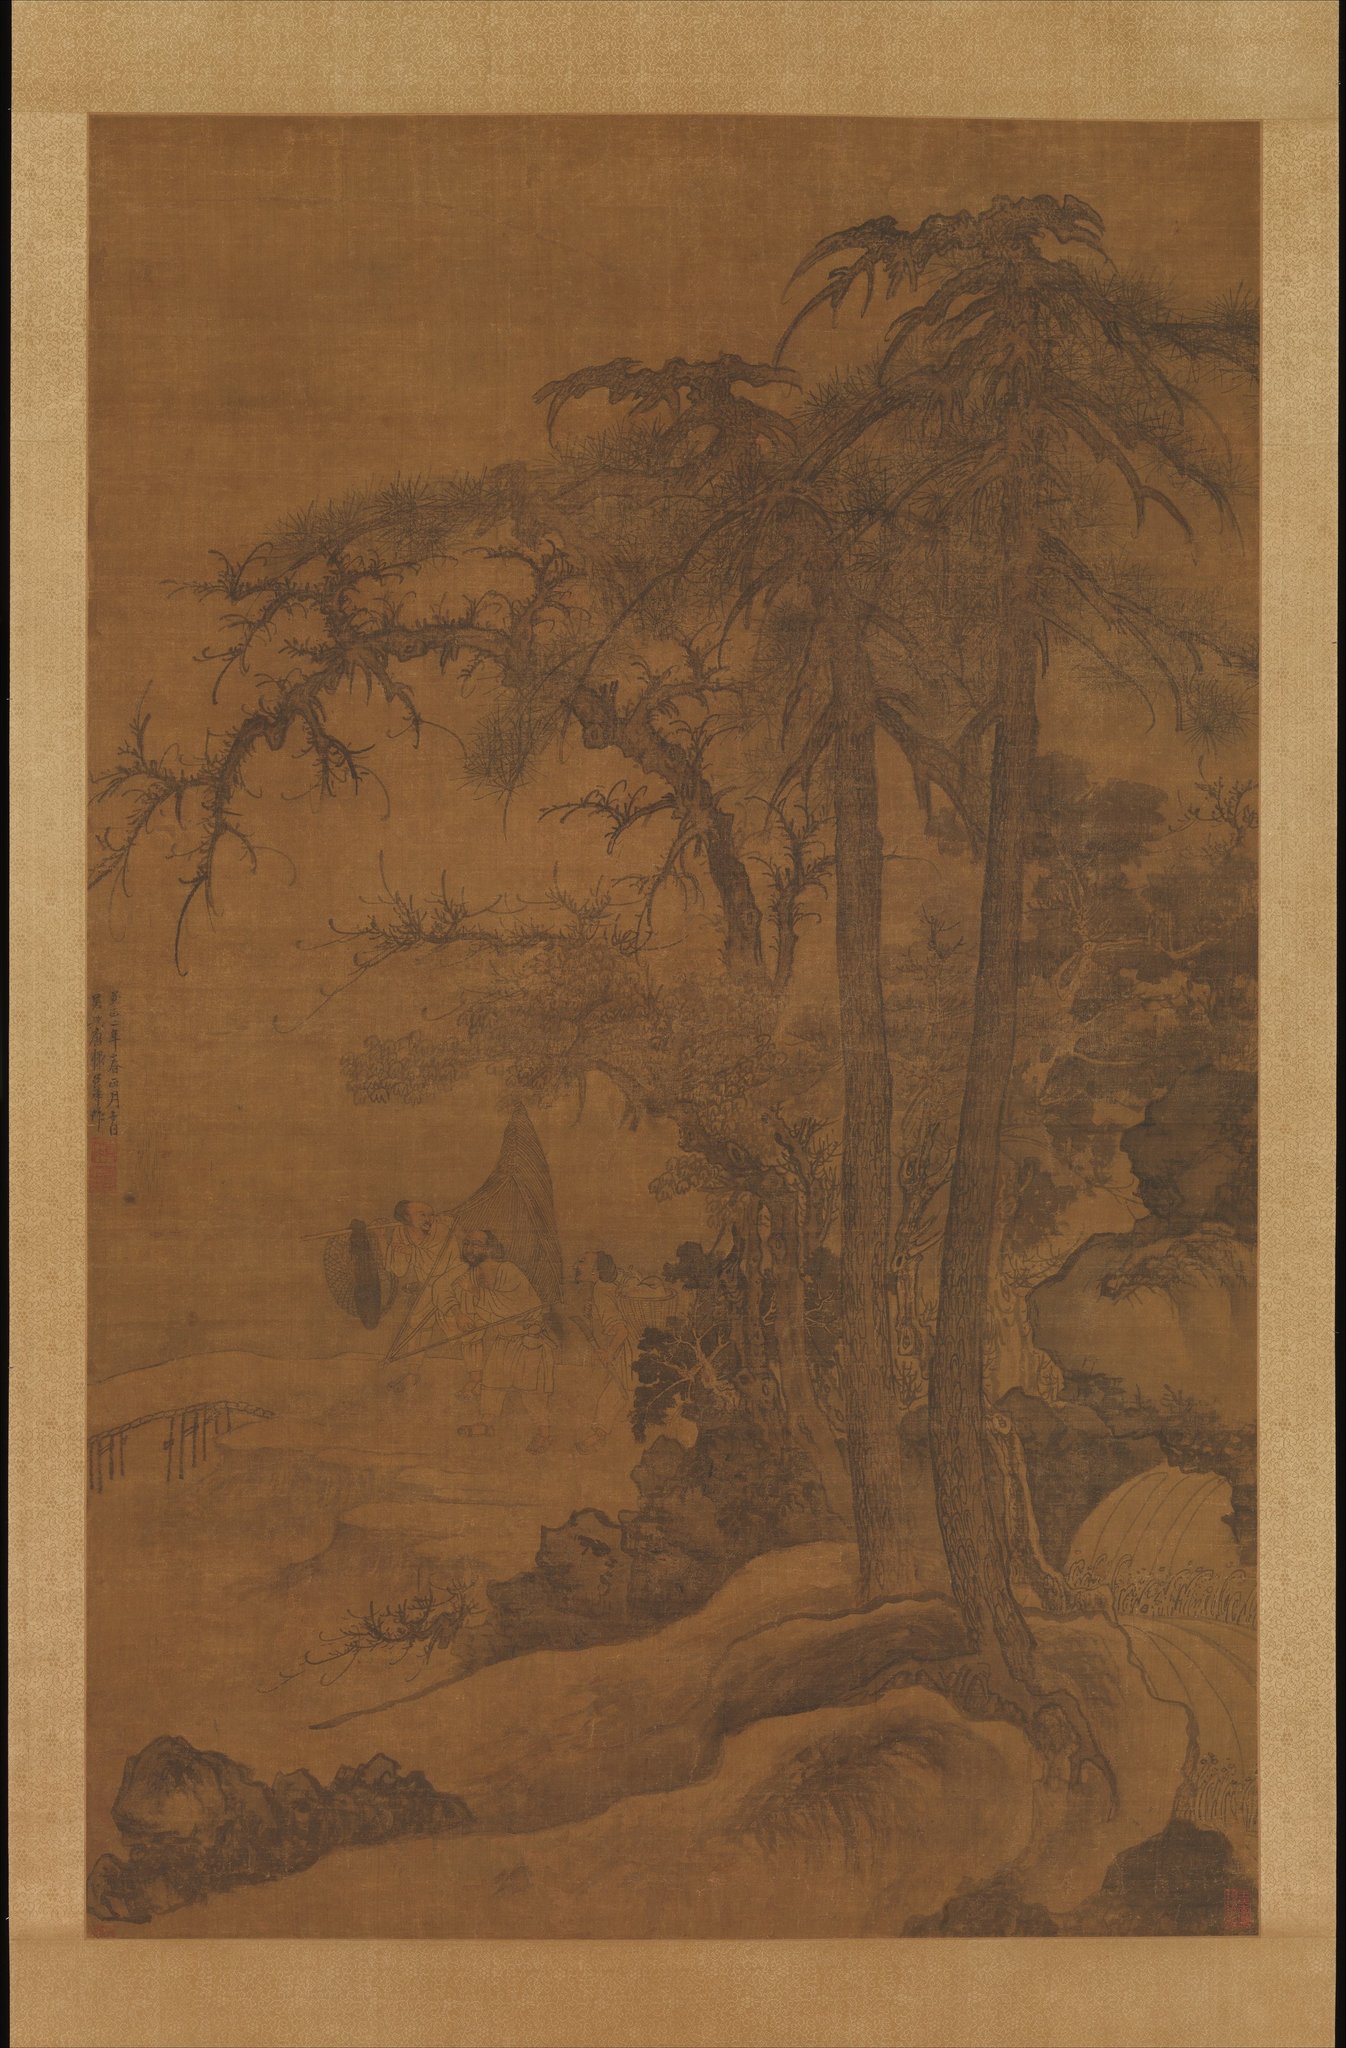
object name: hanging scroll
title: Returning Fishermen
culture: chinese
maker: tang di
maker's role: artist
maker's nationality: chinese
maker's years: 1277-1365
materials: ink, silk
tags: men,trees